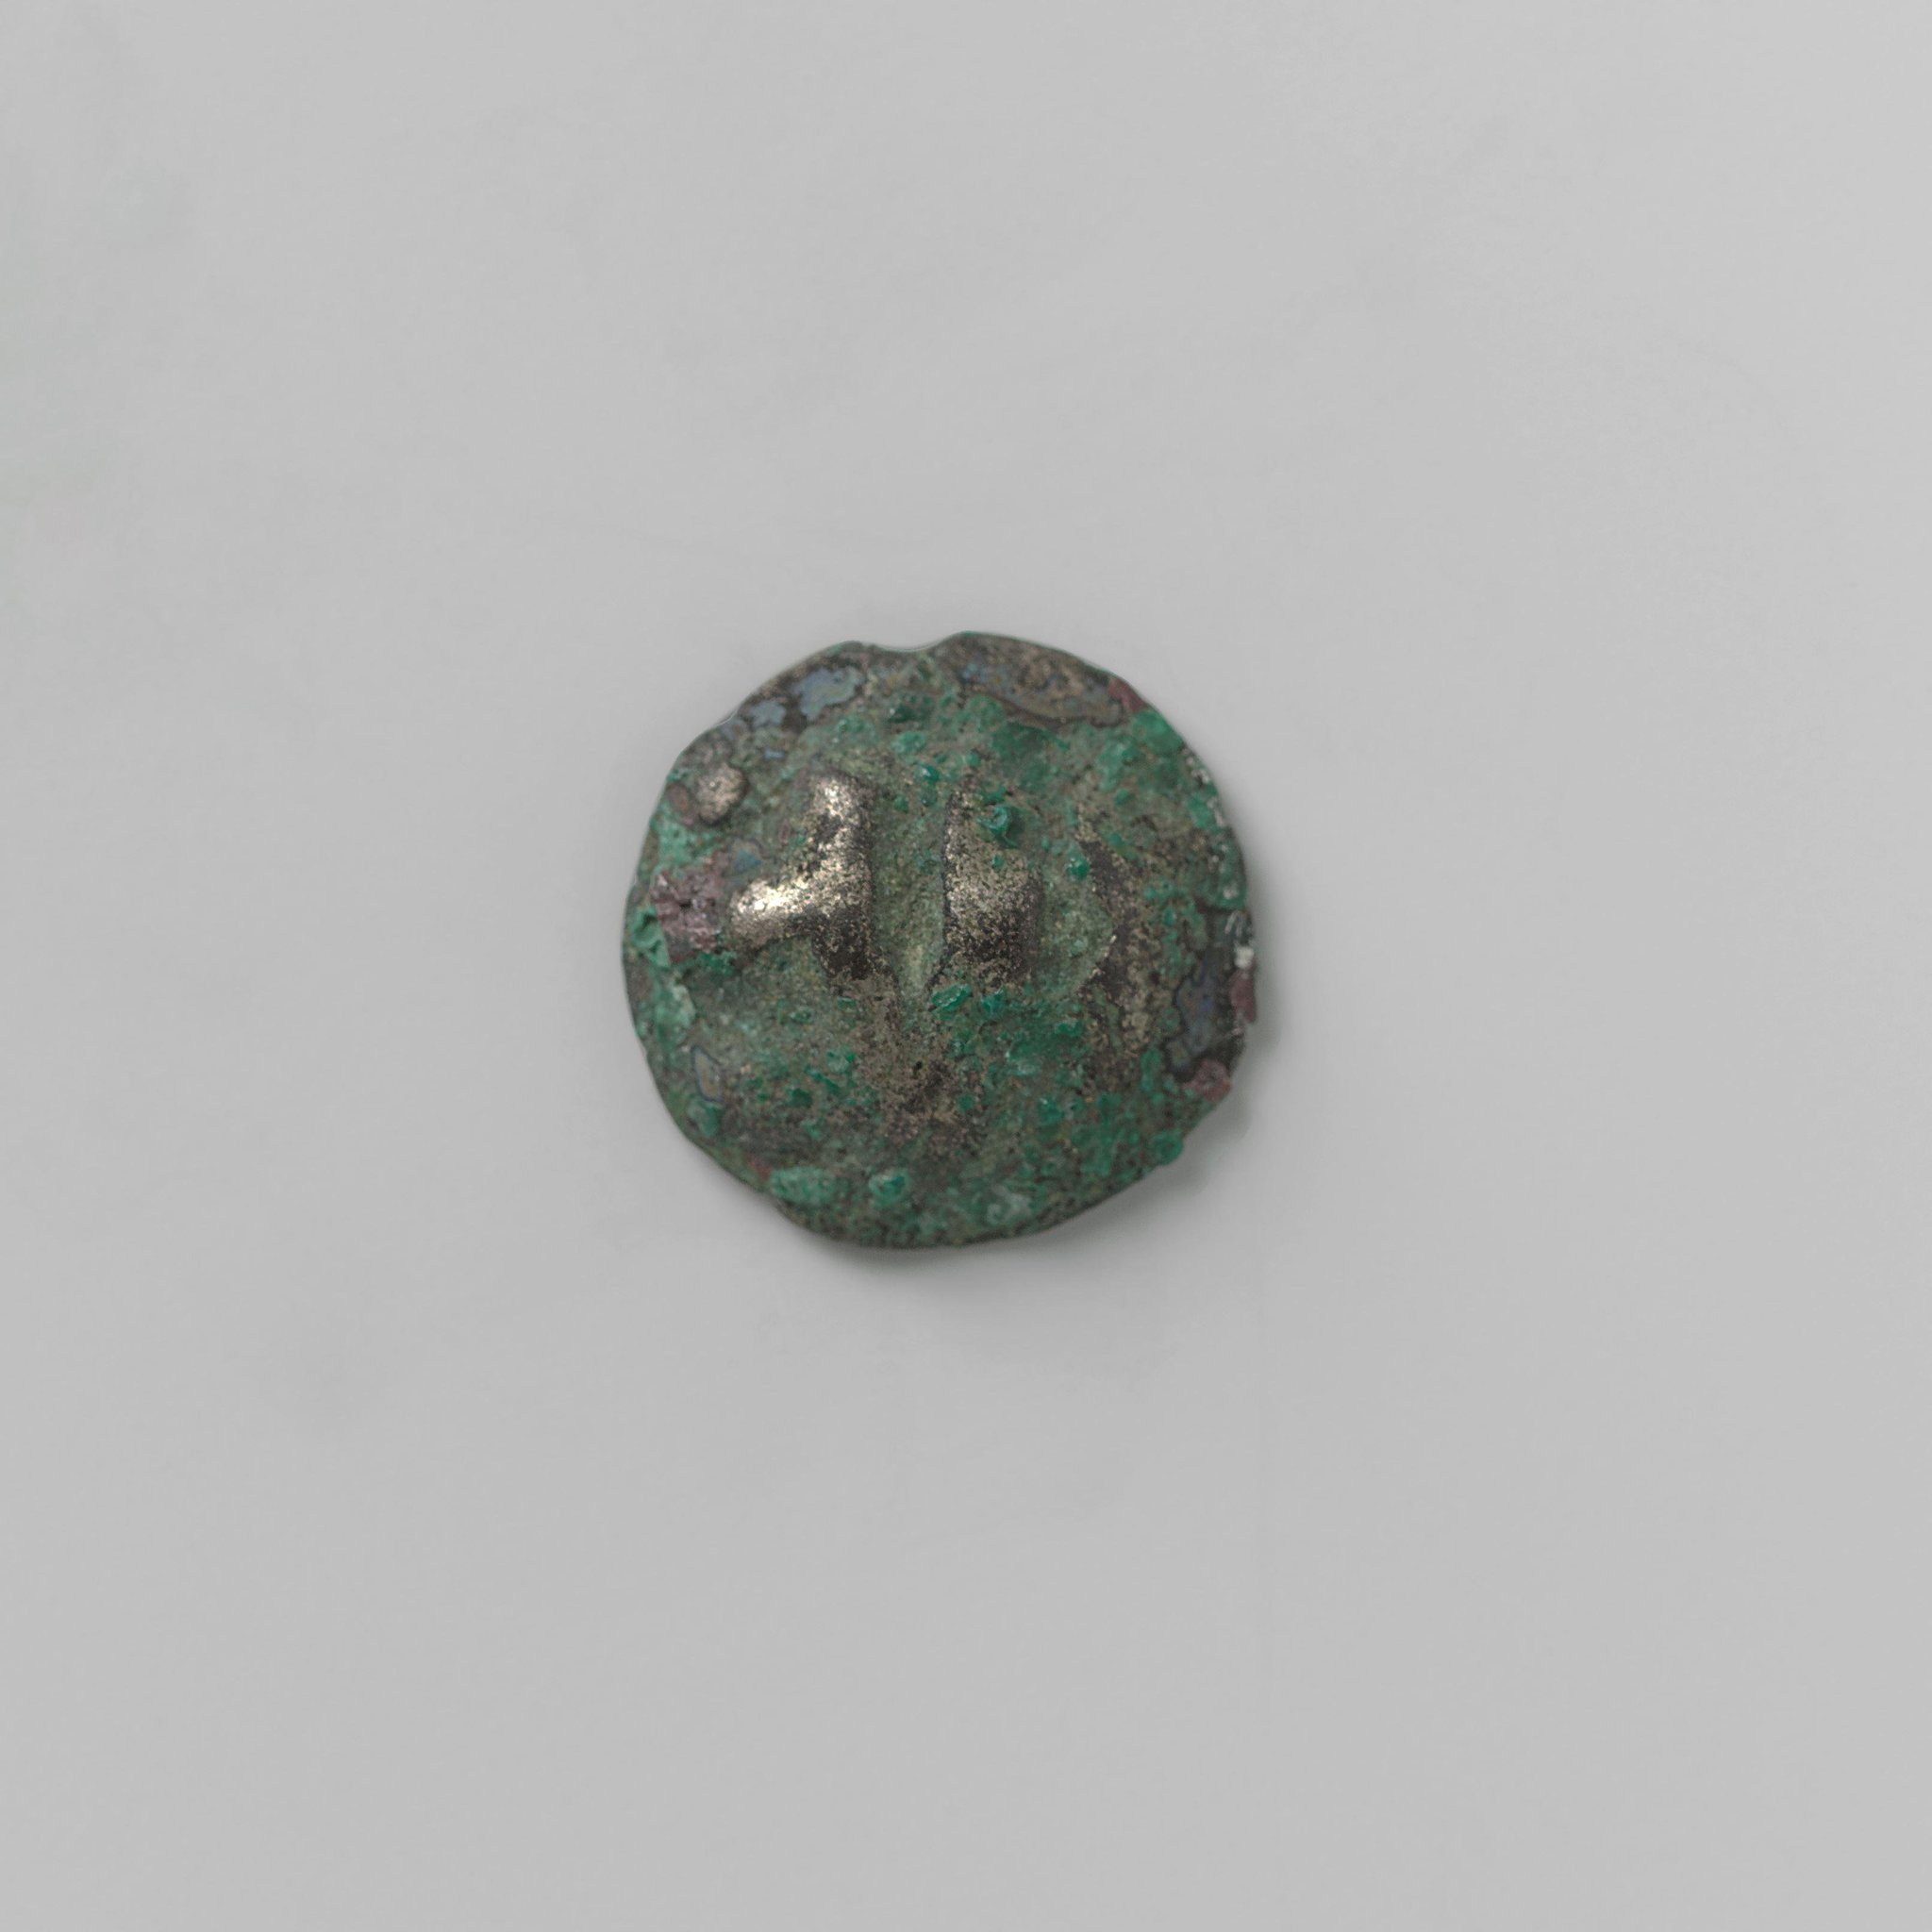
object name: coin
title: Kwart djampel van koninkrijk Majopahit op Java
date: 1290-1520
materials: silver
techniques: striking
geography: java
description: Zilveren schotelvormige munt. Voorzijde: letterteken in devanagari-schrift [maa?]. Keerzijde, figuratie [bloem?].